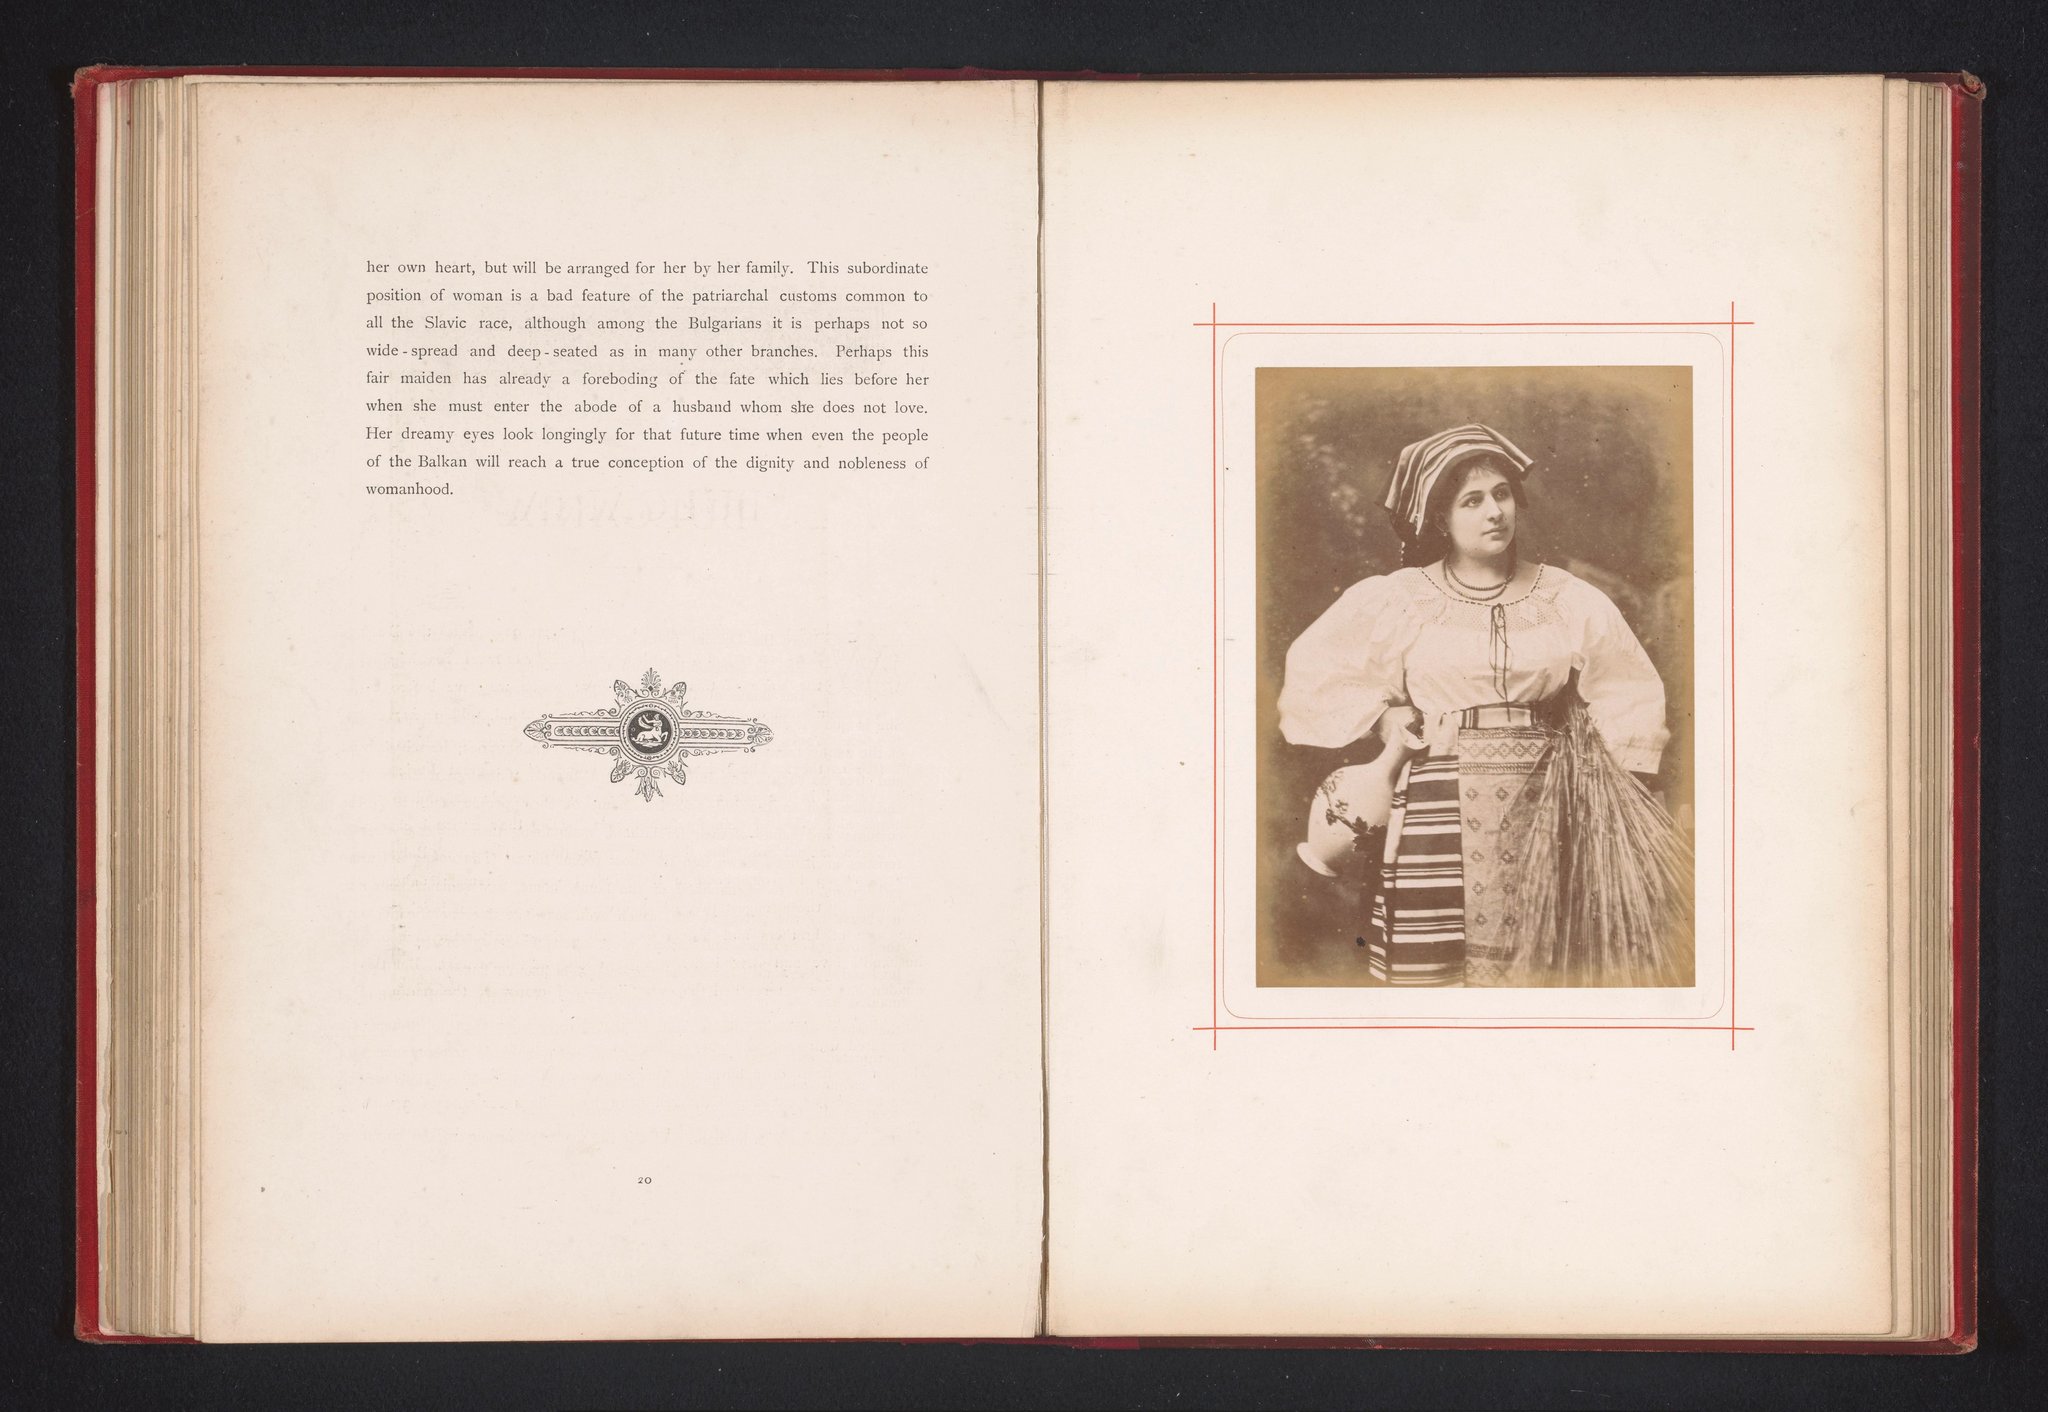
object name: photograph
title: Portret van een onbekende vrouw in klederdracht uit Italië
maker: Anonymous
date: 1876-1886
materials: photographic support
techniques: albumen print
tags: folk costume, regional costume, anonymous historical person portrayed - bb - woman